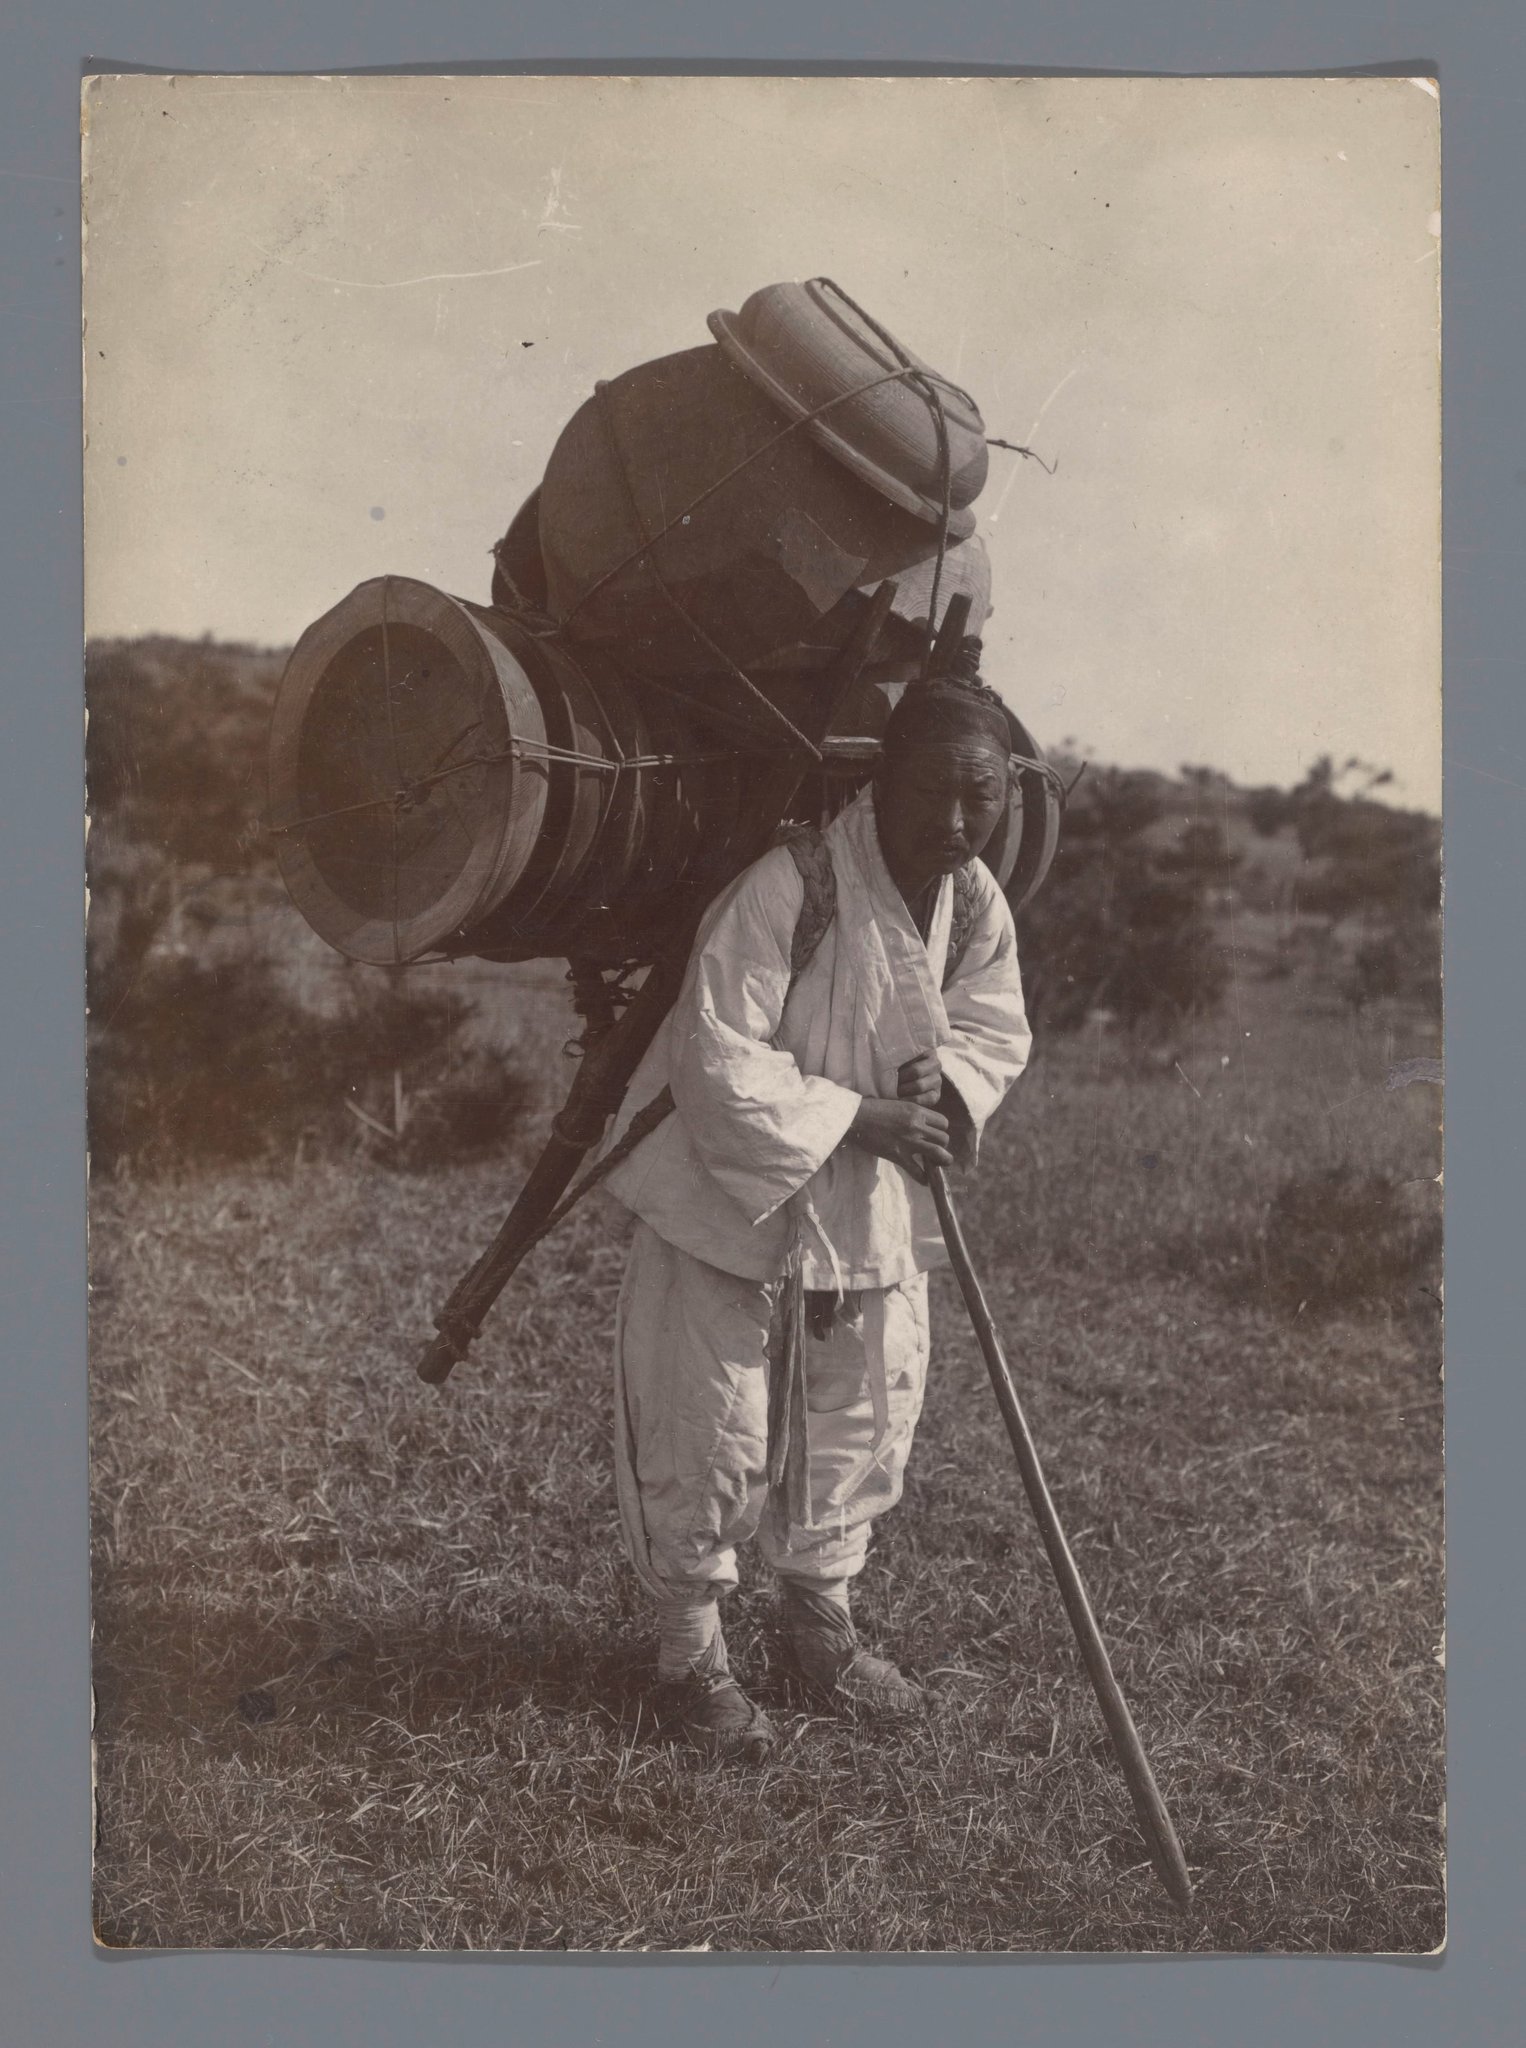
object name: photograph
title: Een Koreaanse man met aardewerk schalen op zijn rug, Korea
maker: jan adriani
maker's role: fotograaf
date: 1907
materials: paper, photographic support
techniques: gelatin silver print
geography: korea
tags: carrying something in basket, bag, rucksack, etc.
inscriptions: inscription: ‘pour l'été prochain (...)’, annotation: ‘Koreaan met zijn (...)’